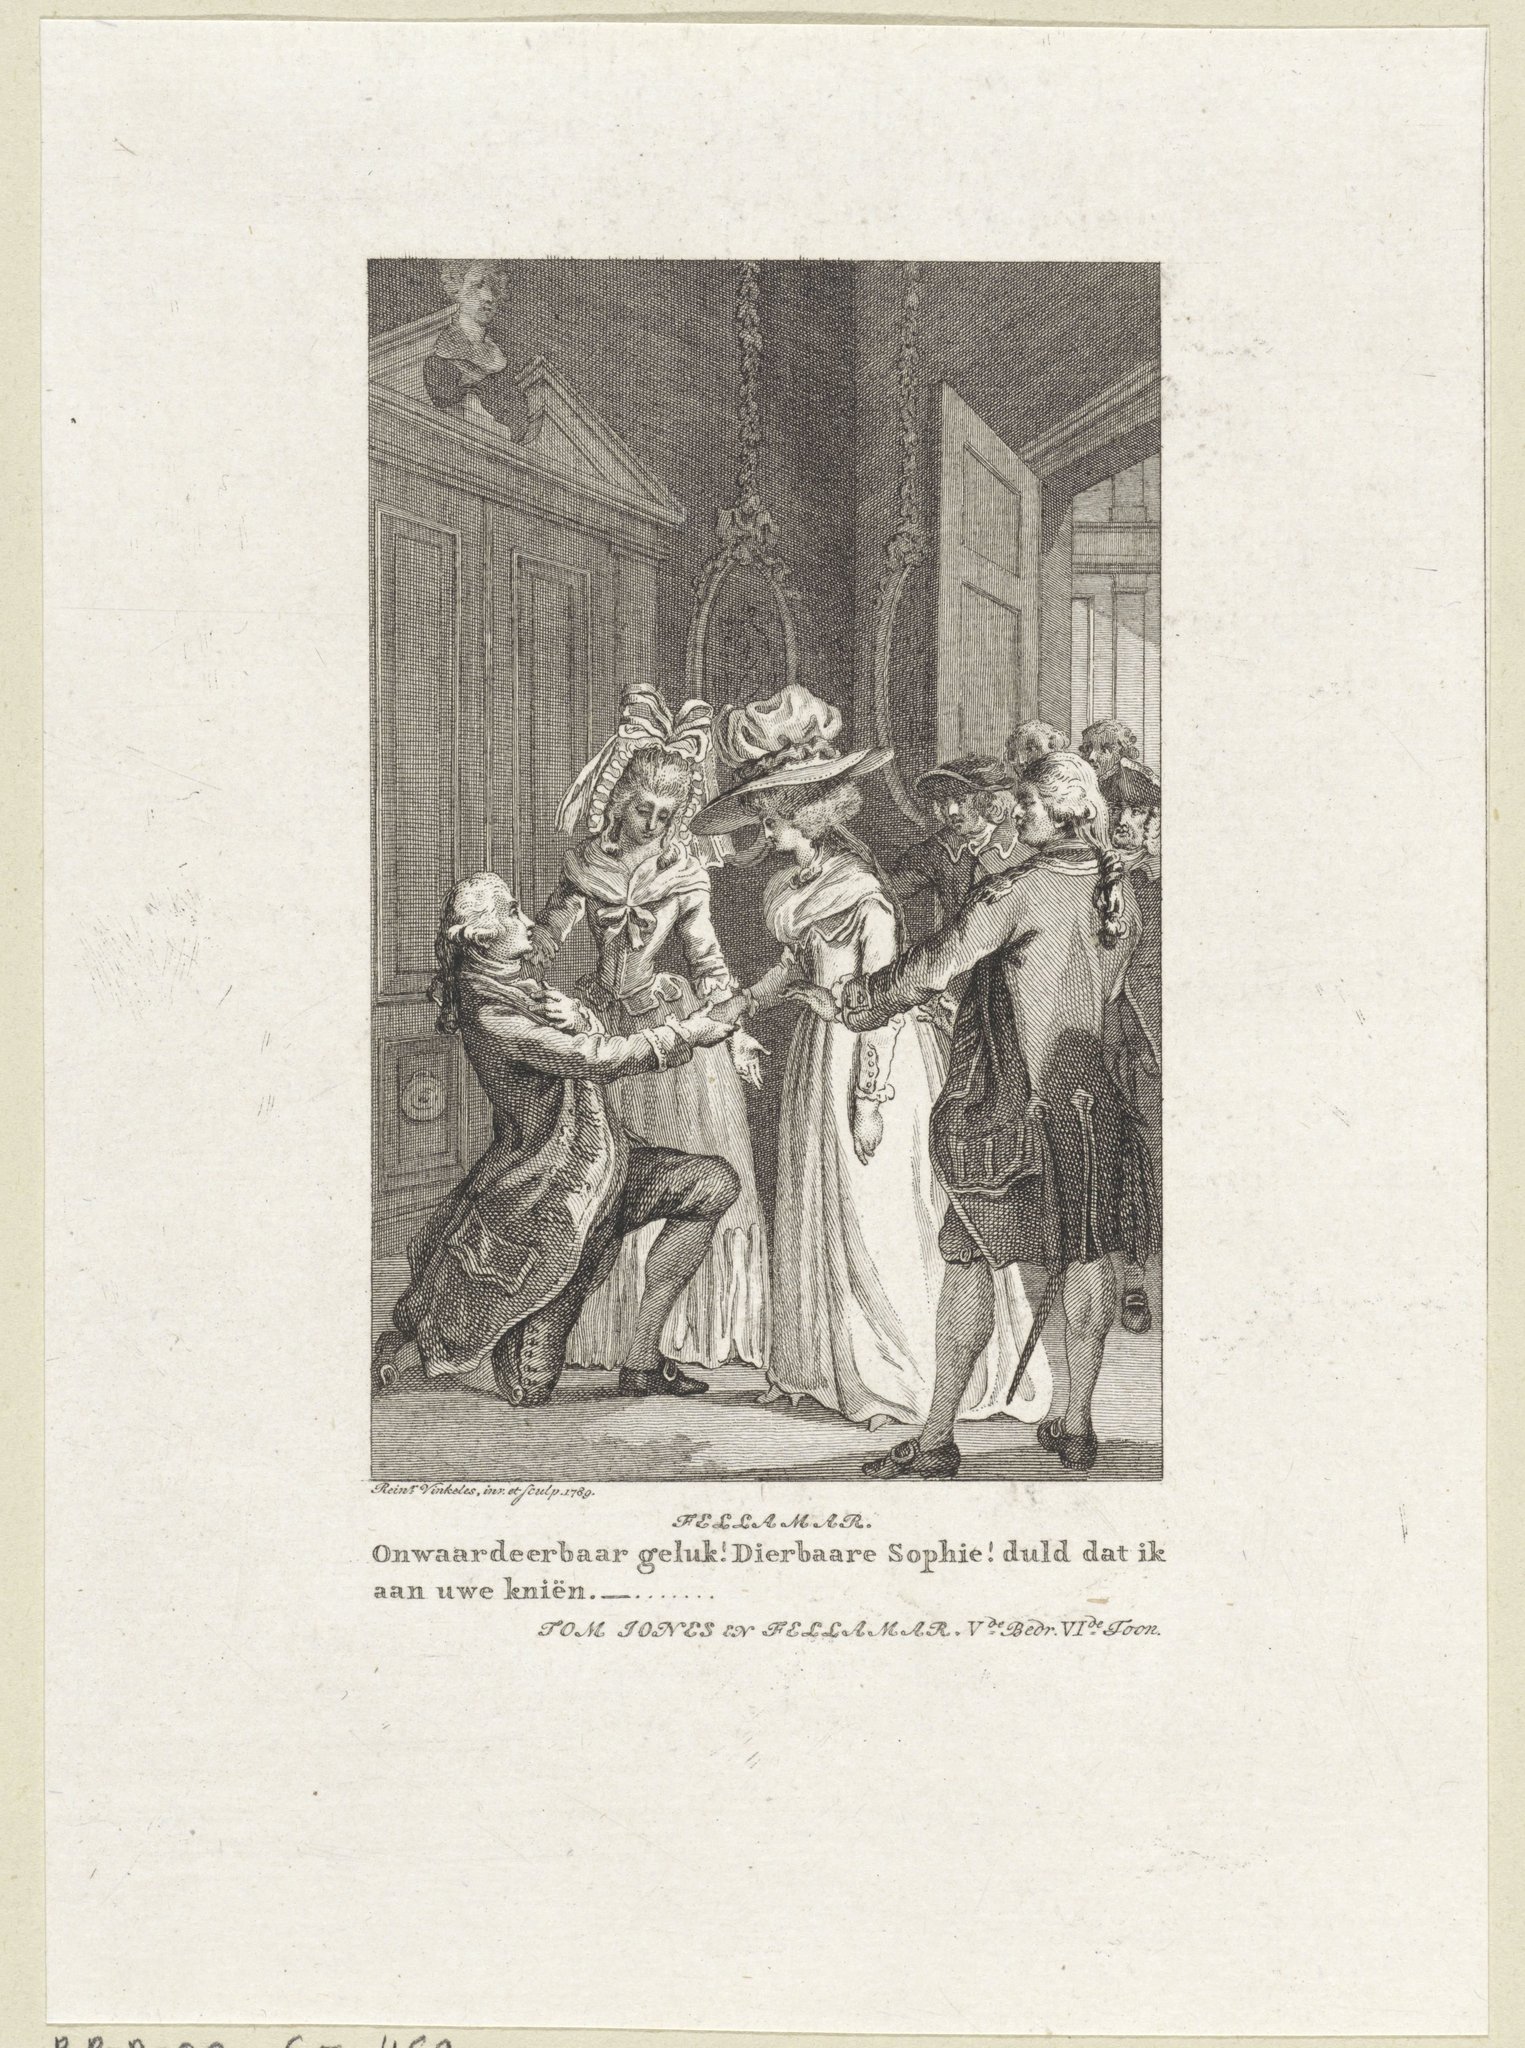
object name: print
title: Man knielt voor een dame, genaamd Sophie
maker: reinier vinkeles (i)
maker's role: draughtsman, print maker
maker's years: 1741-1816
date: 1789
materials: paper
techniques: engraving, etching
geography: amsterdam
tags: man kneeling before his beloved (proposing)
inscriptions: collector's mark: Lugt 240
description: Deze prent is mogelijk ook gebruikt als illustratie in: Fielding, Henry. Tom Jones en Fellamar. Amsterdam: erven van Pieter Meĳer en Gerrit Warnars, 1789.